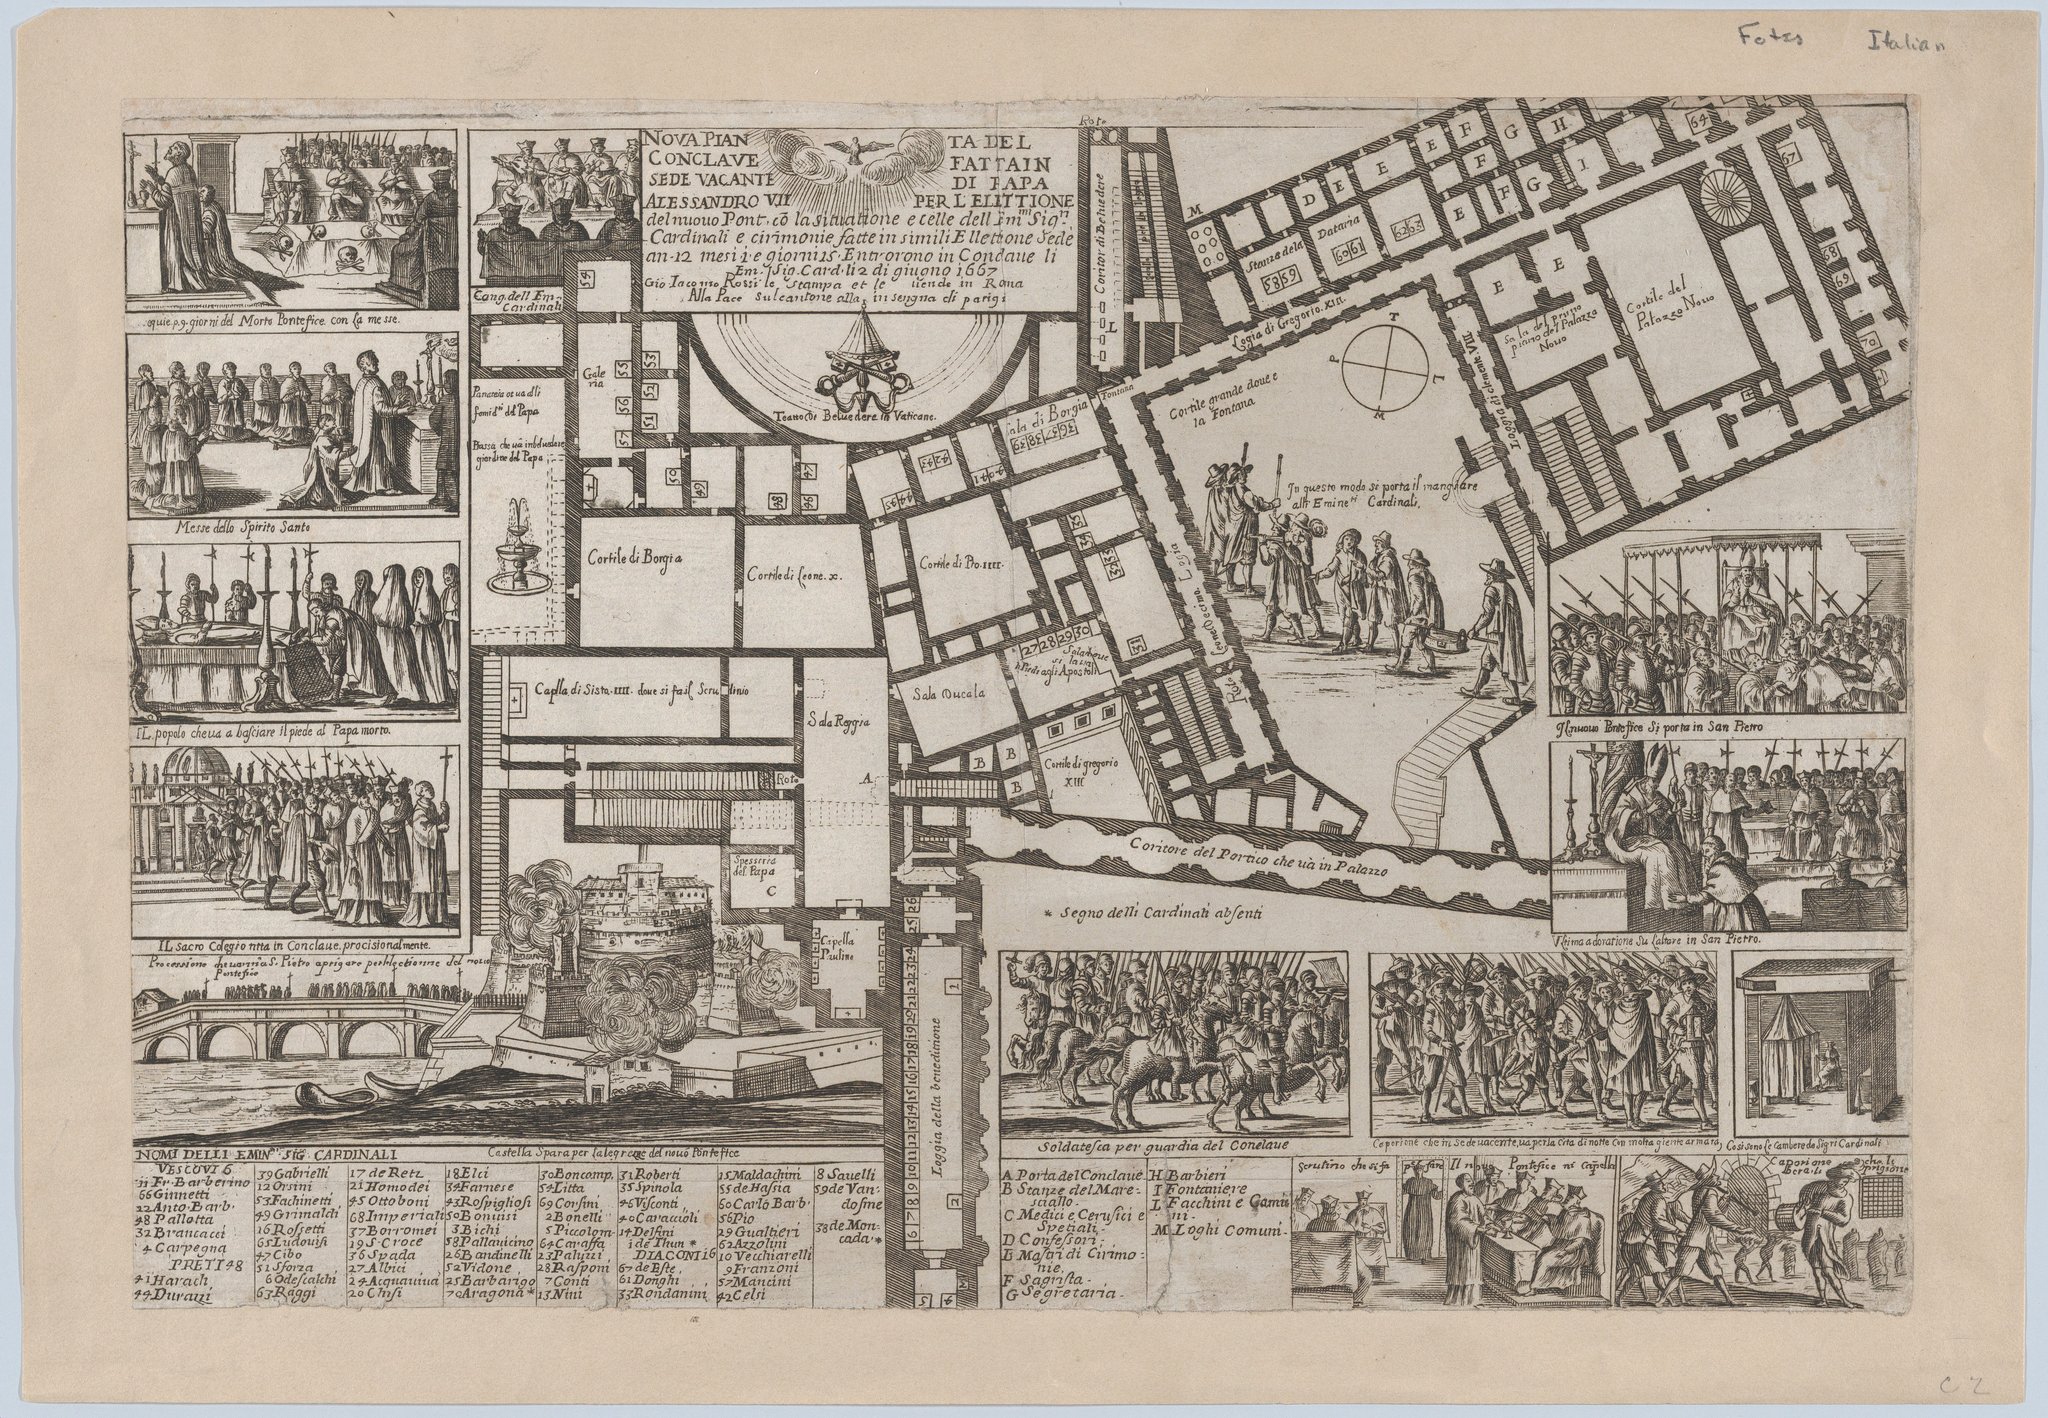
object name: print, fete, ornament architecture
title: Papal conclave following the death of Pope Alessandro VII, with an iconographic map of Vatican City and scenes of the funeral, procession, and election of the new pope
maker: giovanni giacomo de rossi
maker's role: publisher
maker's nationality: italian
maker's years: 1627-1691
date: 1667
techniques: etching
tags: horses,popes,funerals,maps